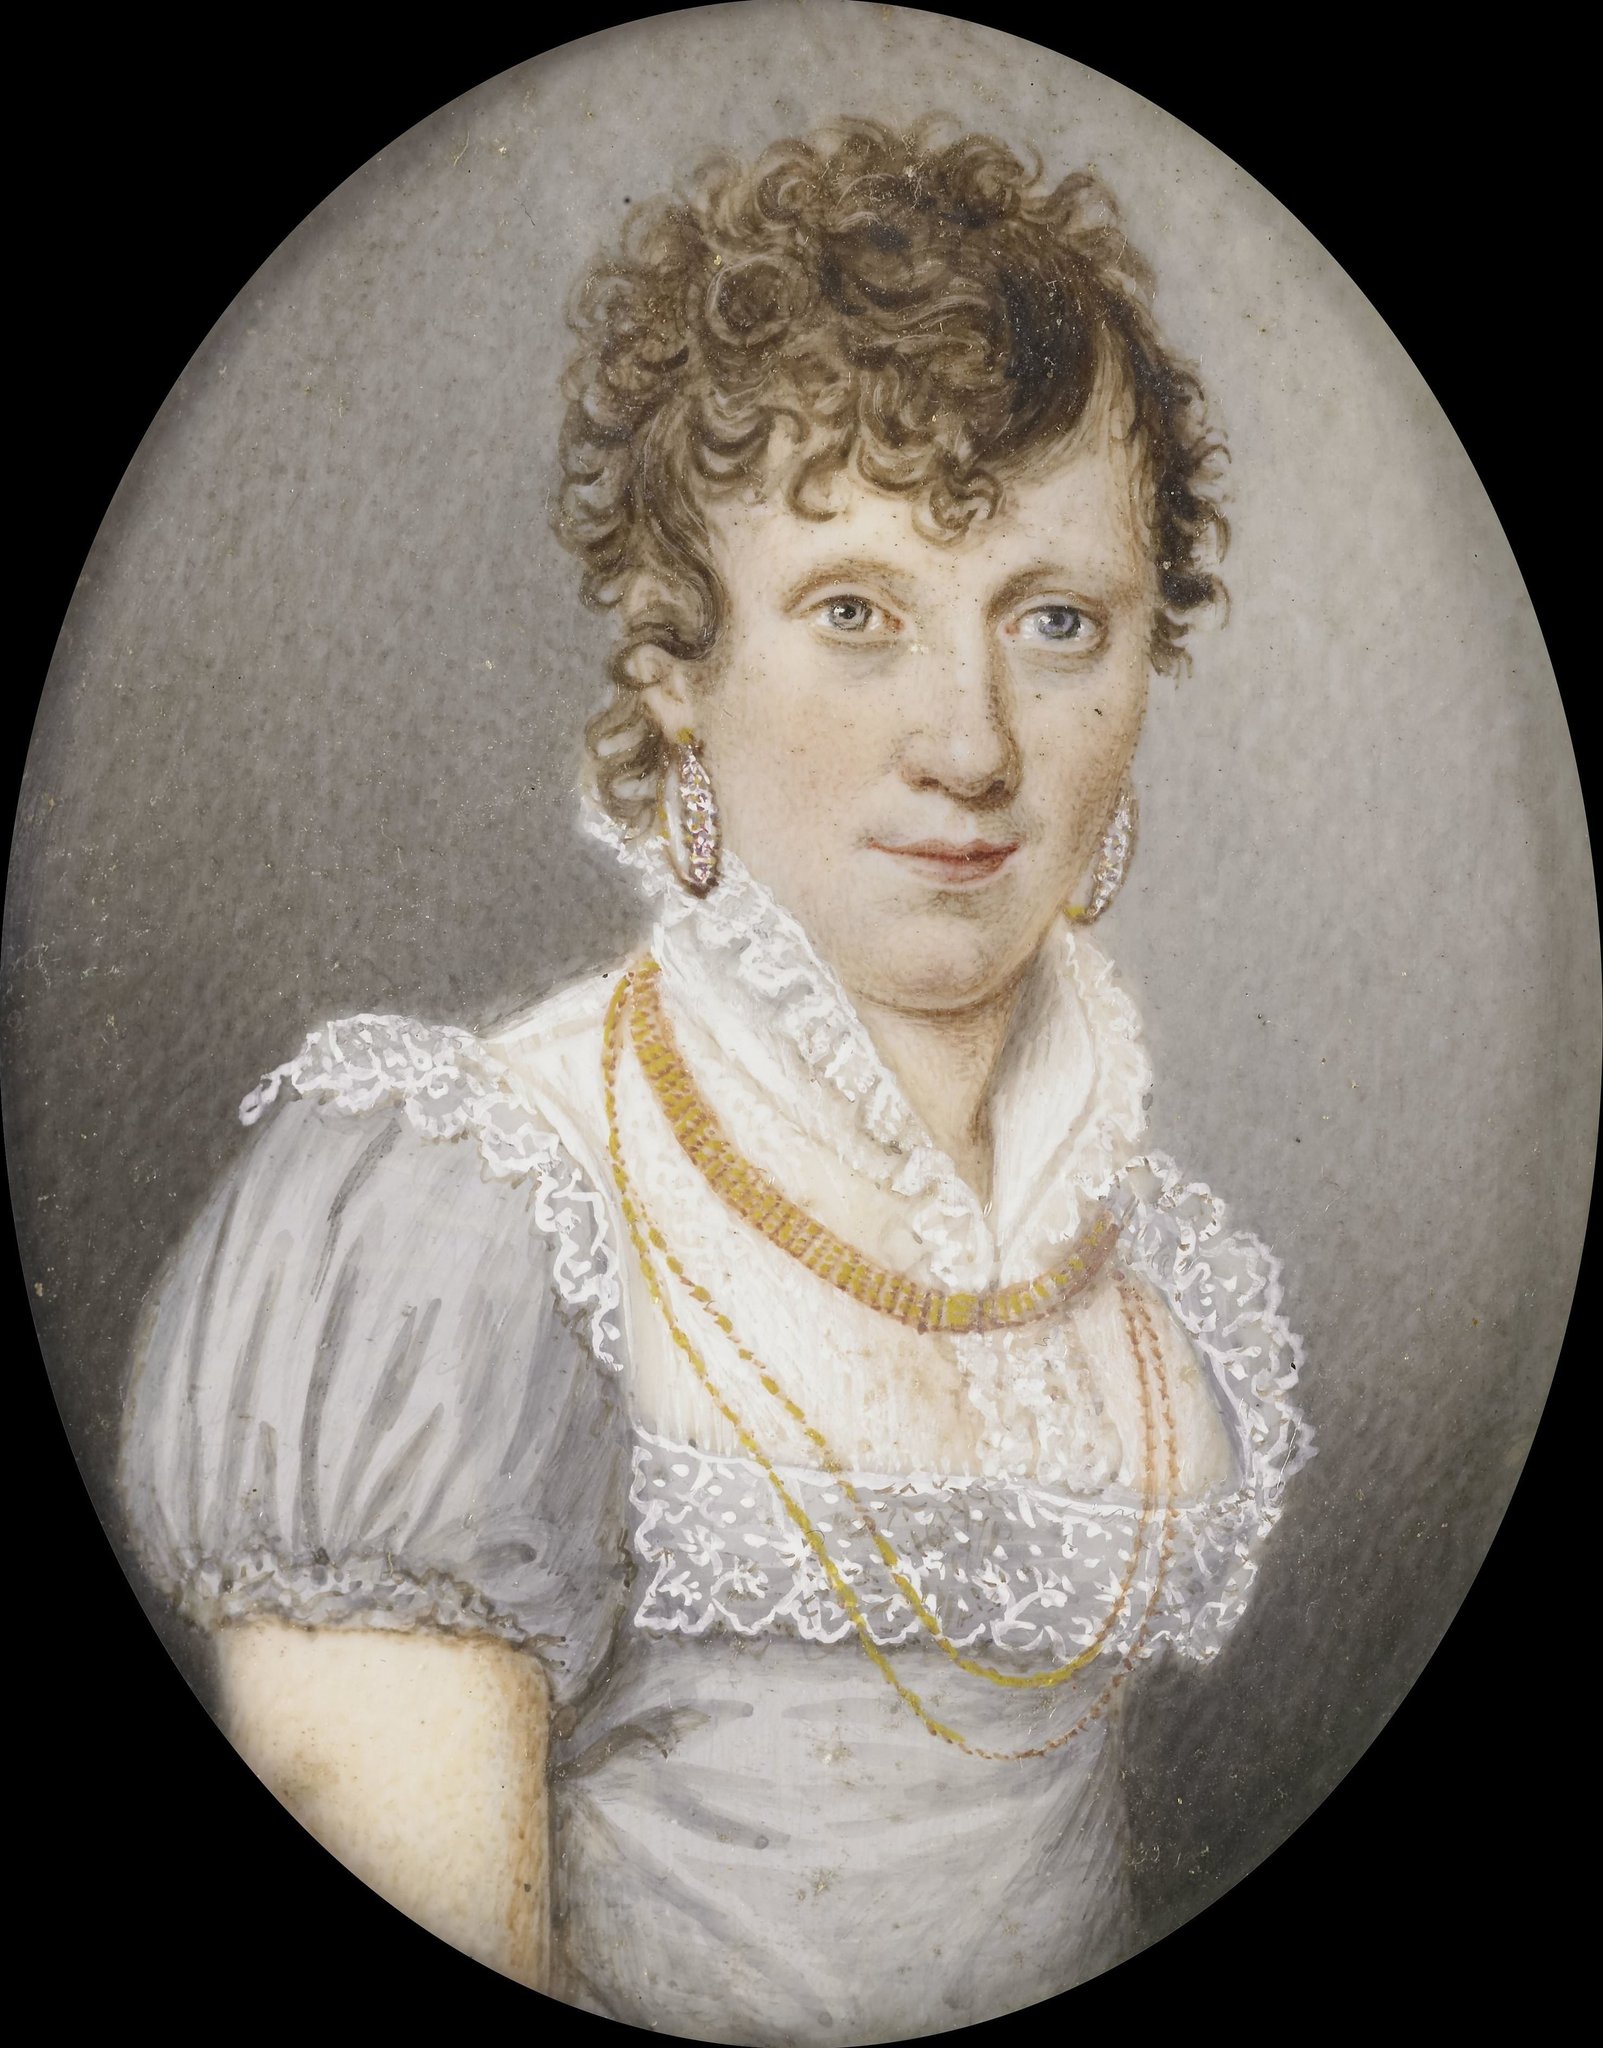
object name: painting, miniature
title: Maria Elisabeth Schreiber (1765-1822). Echtgenote van Georg Albrecht Diederichs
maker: Anonymous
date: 1810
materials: glass, ivory, lacquer, metal, wood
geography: northern netherlands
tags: historical persons - bb - woman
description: Maria Elisabeth Schreiber (1765 - 1822), wife of George Albrecht Diederichs. Northern Netherlands school. Ivory, c. 1810.